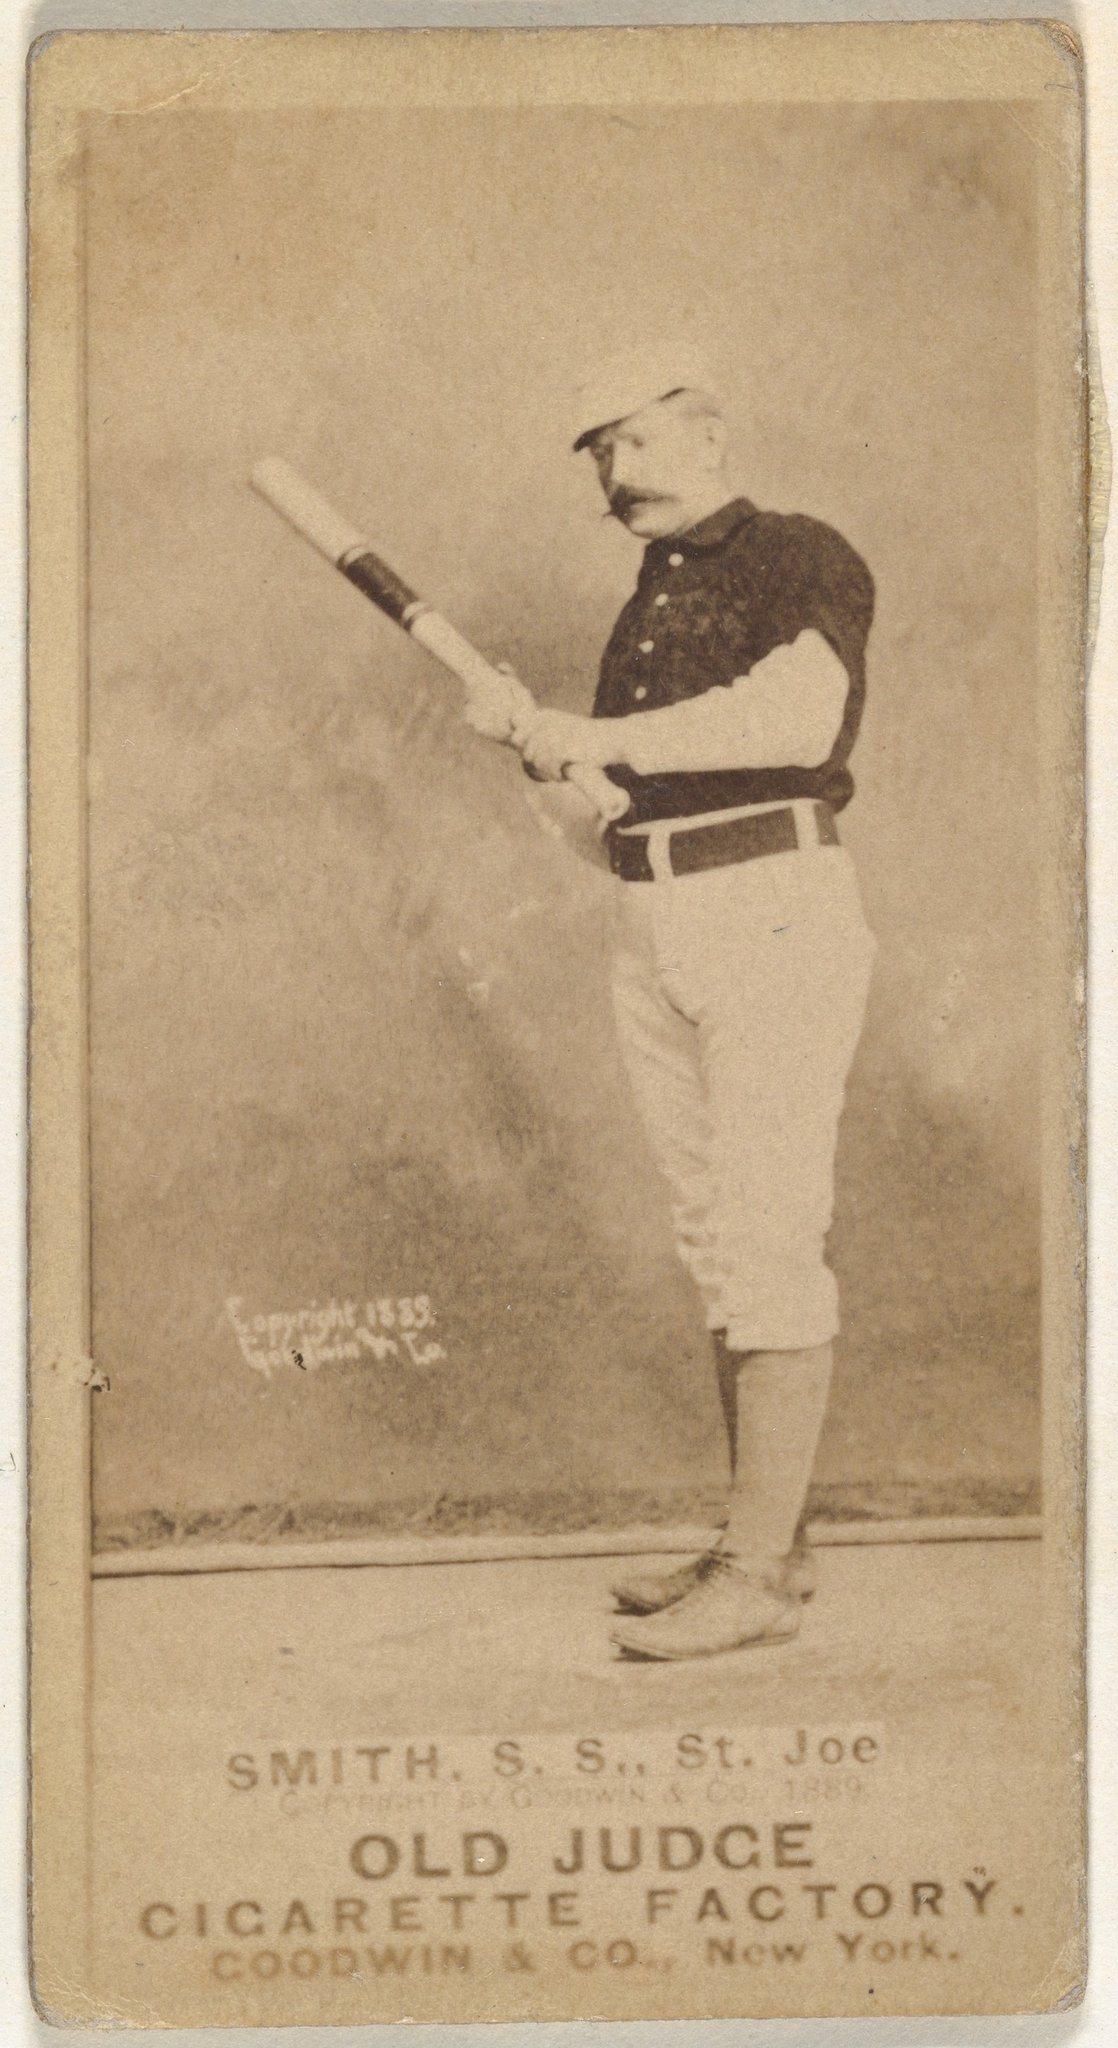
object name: baseball card, photograph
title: H. Smith, Shortstop, St. Joseph Clay Eaters, from the Old Judge series (N172) for Old Judge Cigarettes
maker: goodwin & company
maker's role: publisher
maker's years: 1850-1950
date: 1889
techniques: albumen silver print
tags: men,portraits,baseball,athletes